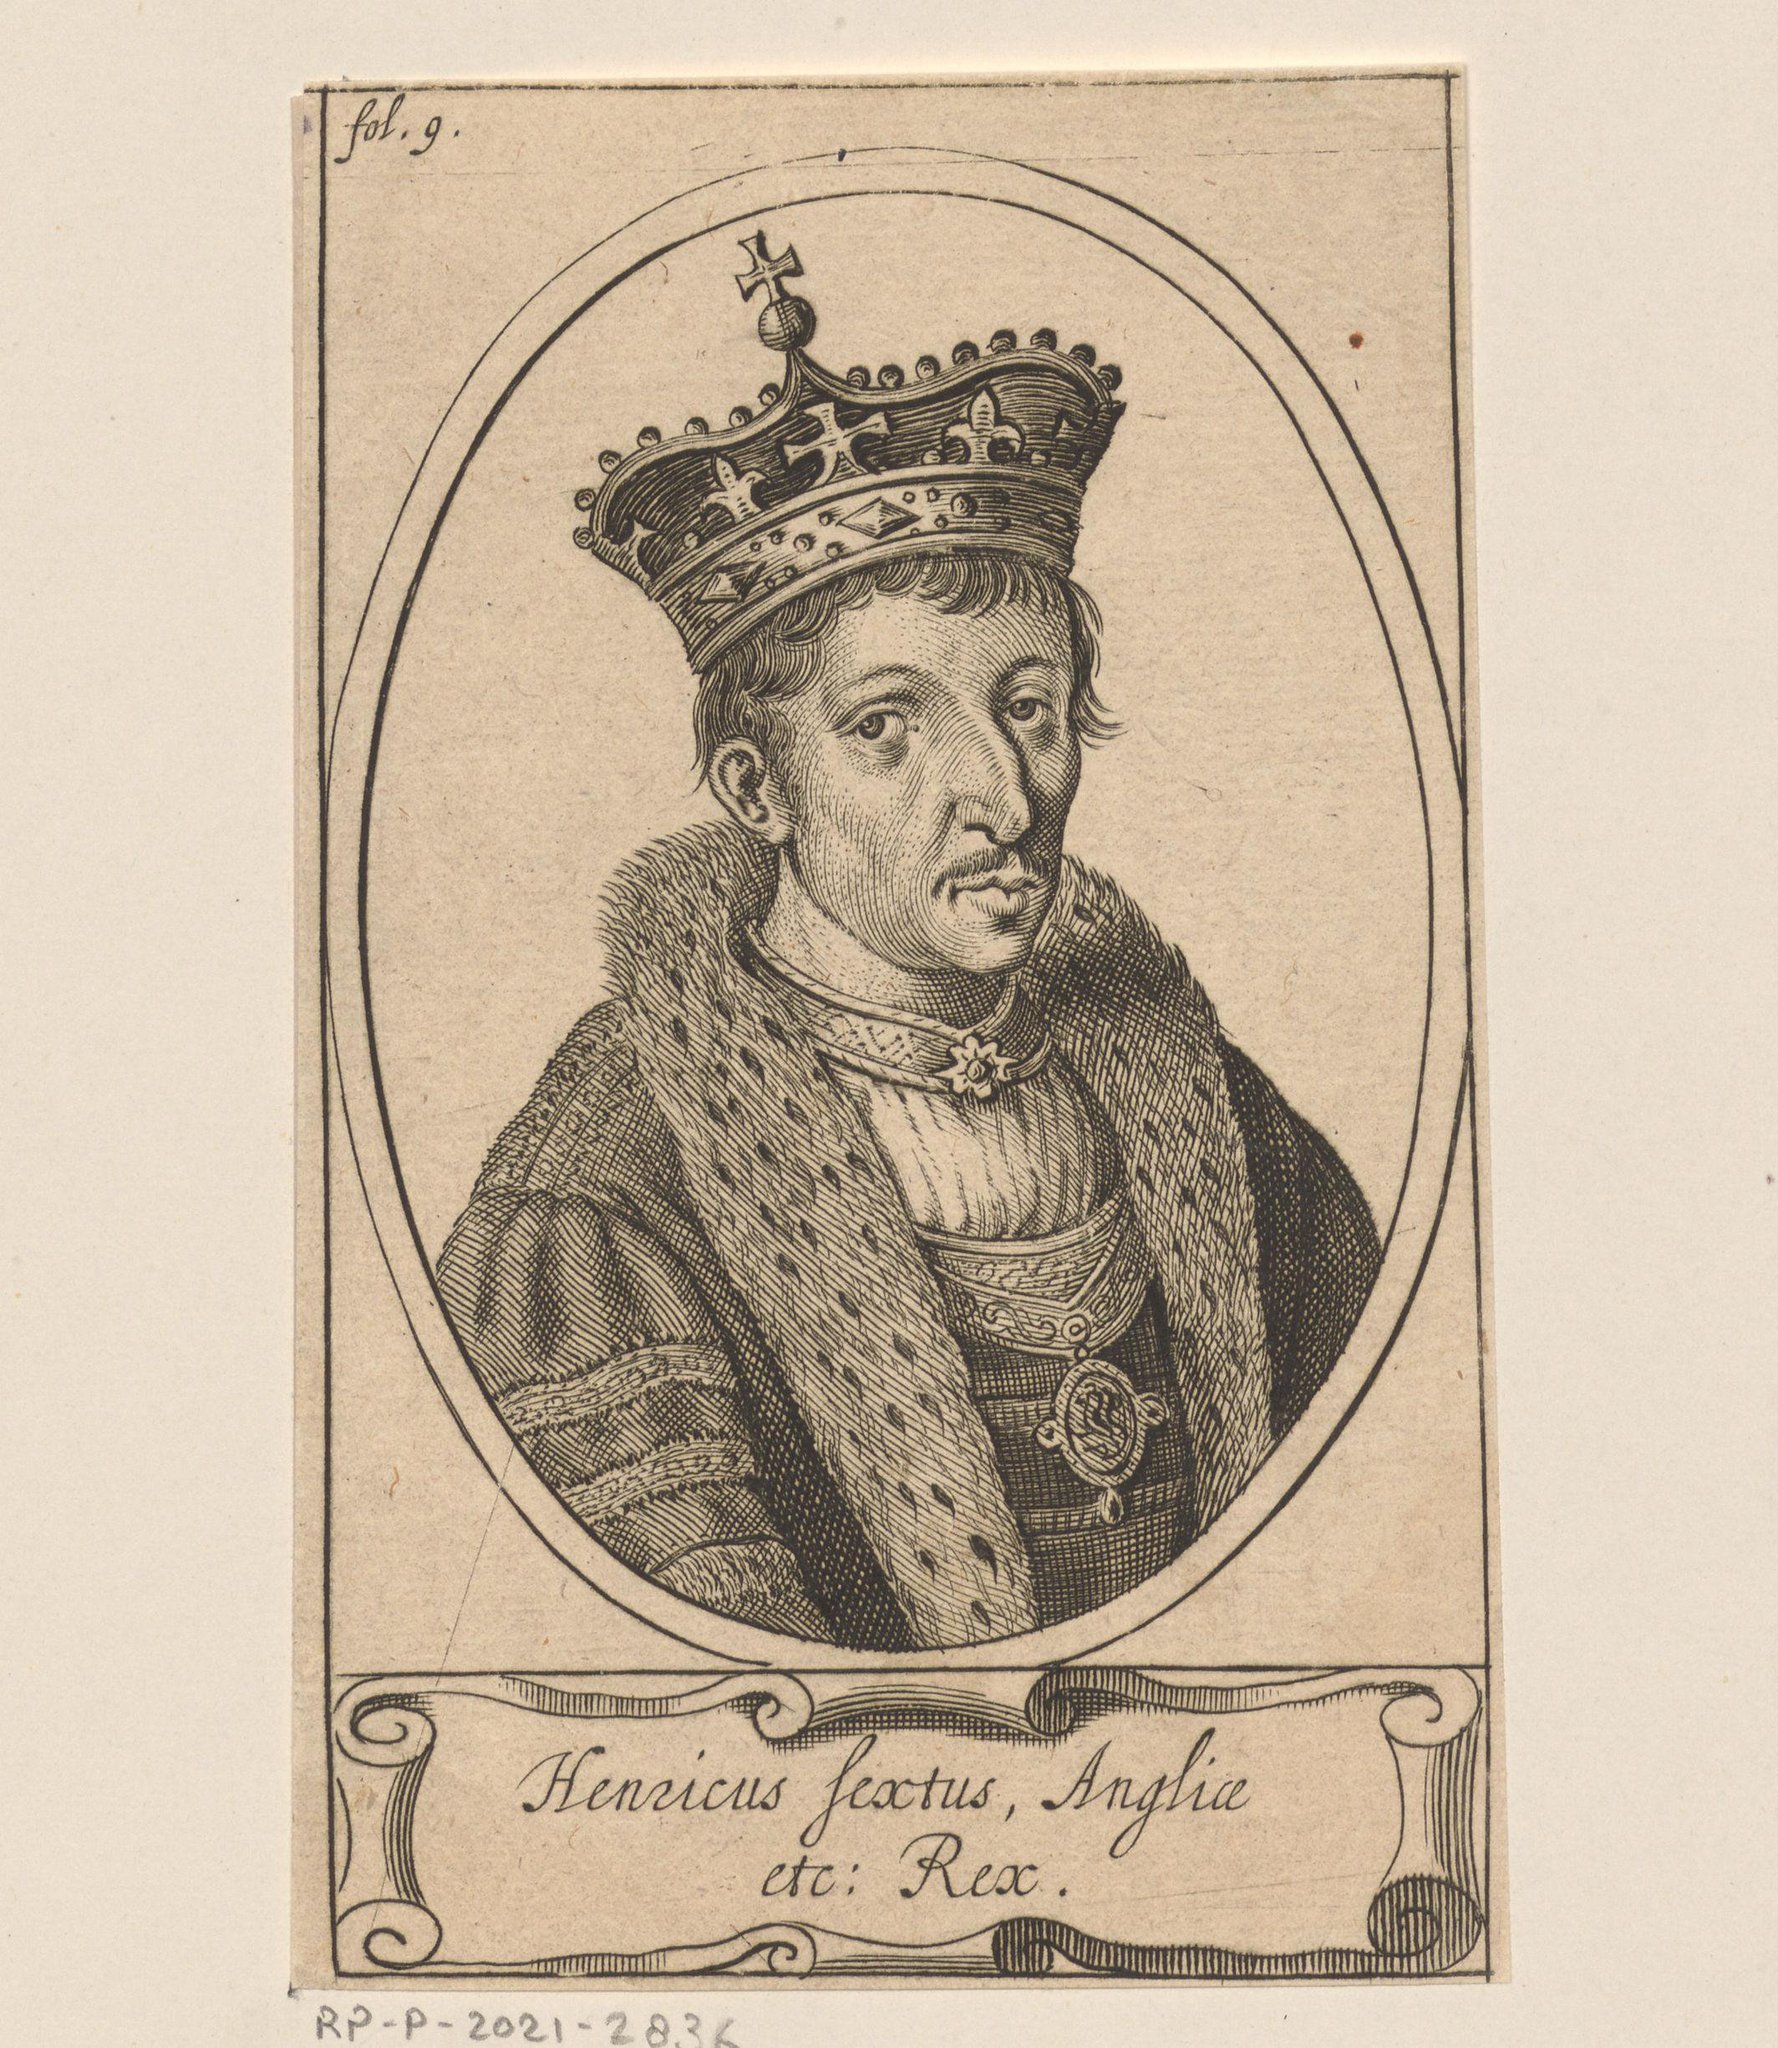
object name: print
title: Portret van Hendrik VI, koning van Engeland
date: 1652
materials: paper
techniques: engraving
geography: amsterdam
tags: london, historical persons, king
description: Prent uit: Bos, Lambert van den. Het vorstelyck treurtoonneel, of op- en onder-gangh der grooten. Amsterdam: Nicolaes van Ravesteyn, 1652. Prent mogelijk ook gebruikt in de 1655- en de 1658-editie.